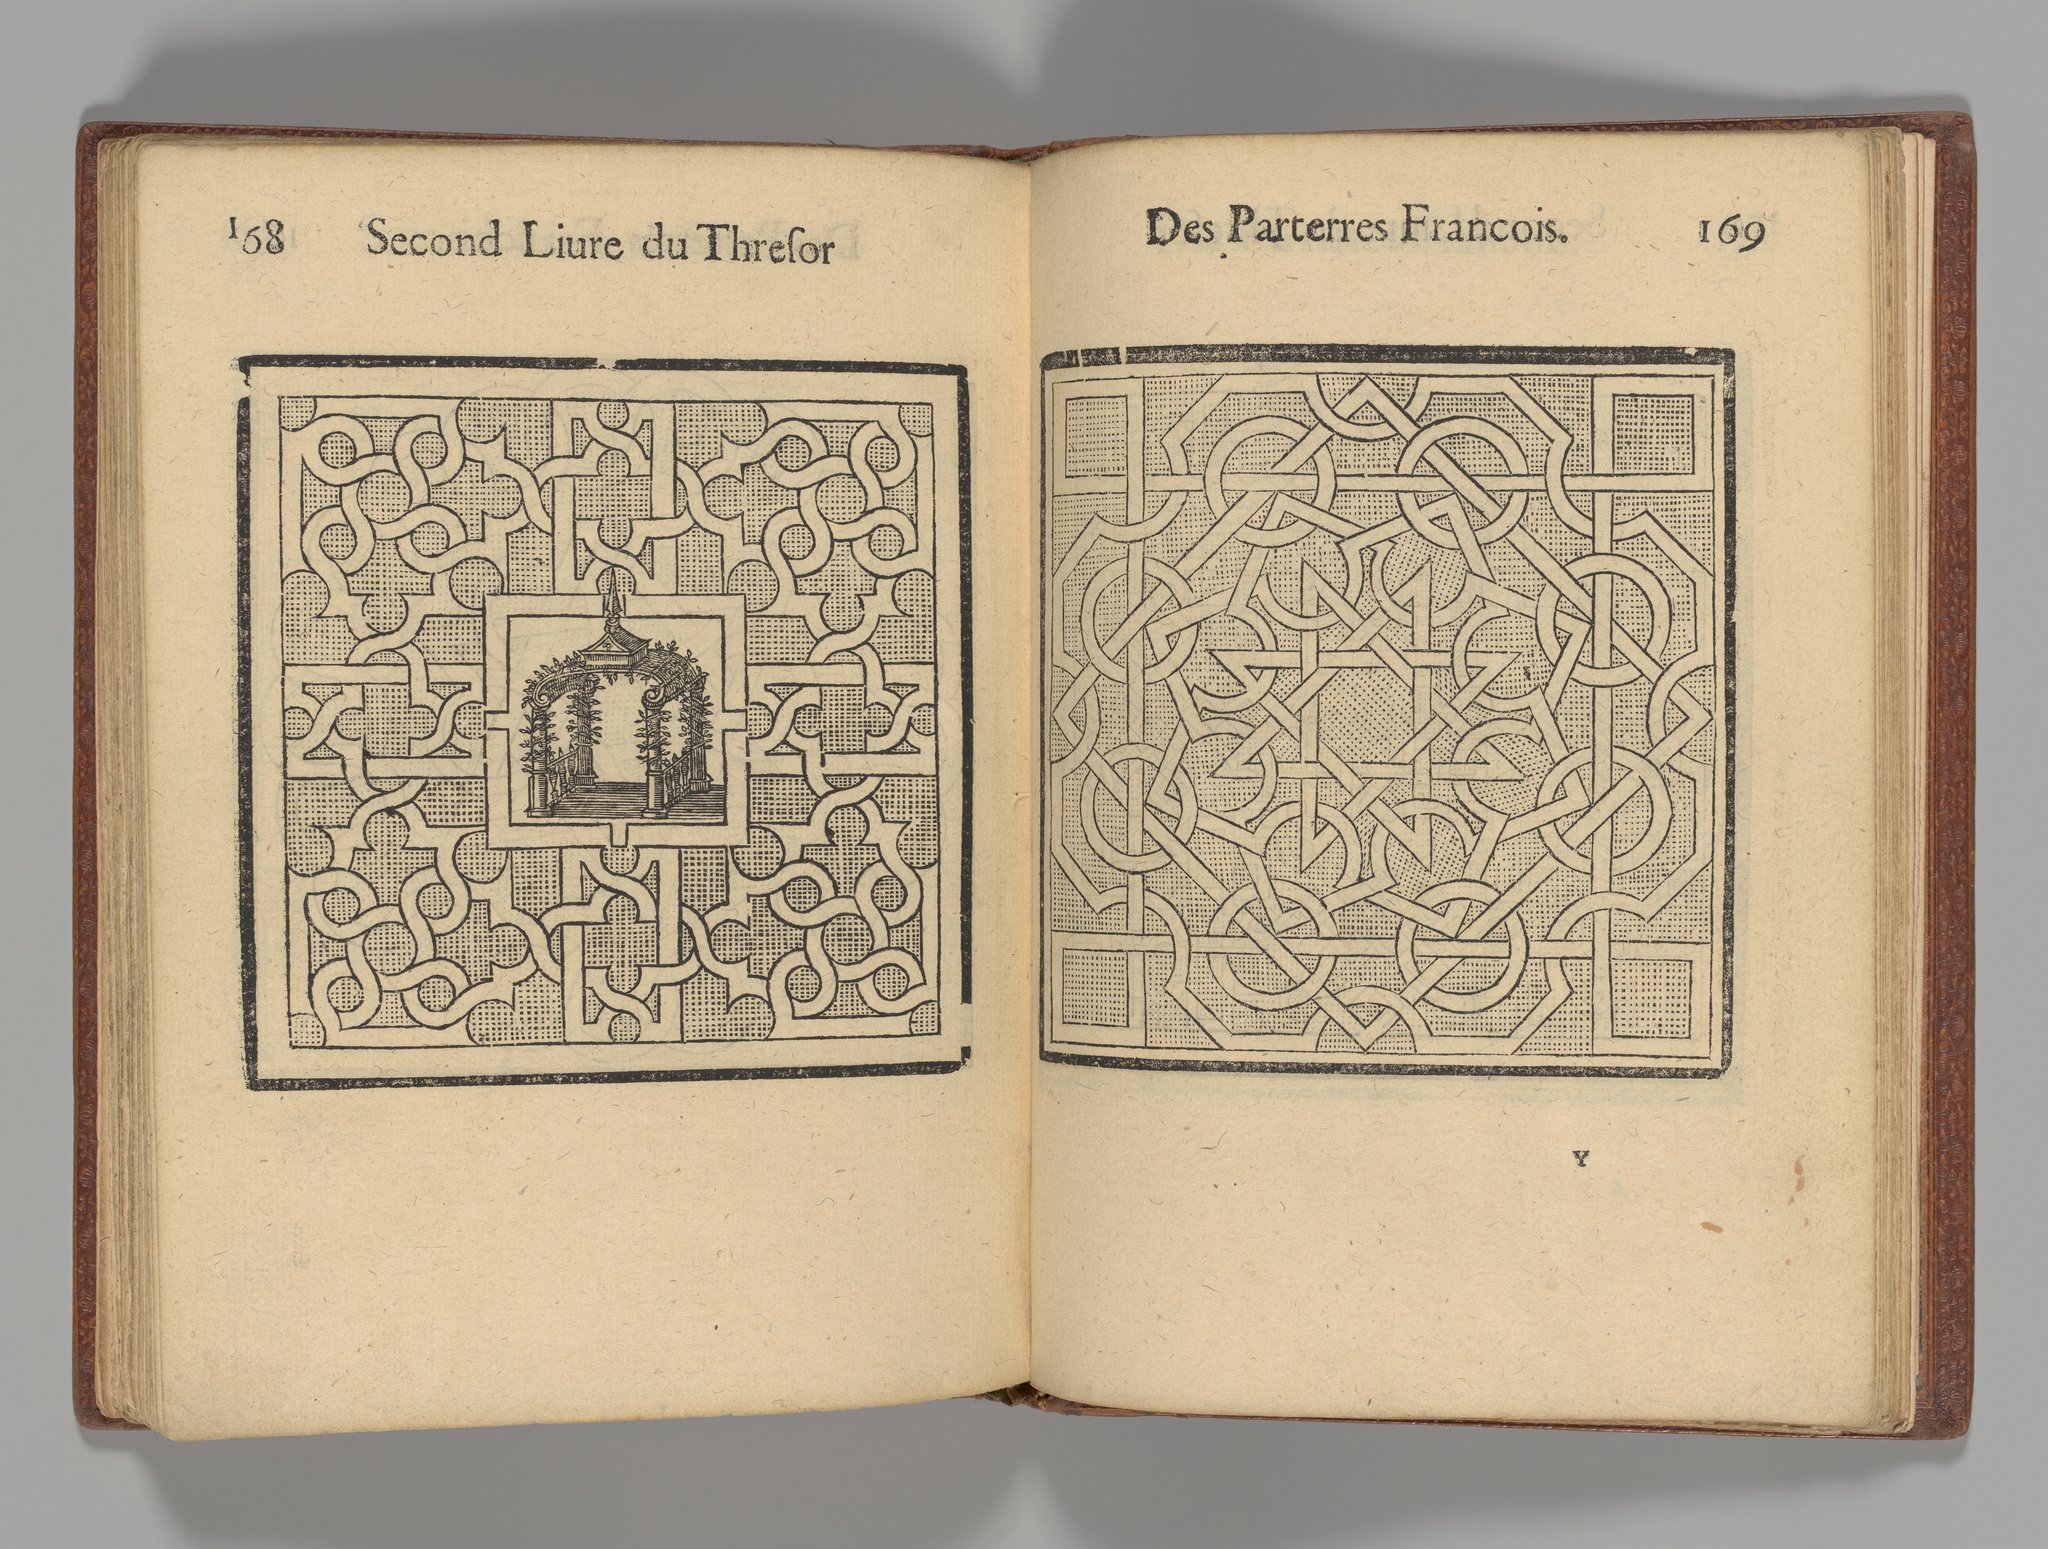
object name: book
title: Le Thresor des Parterres de l'Univers, Contenant les Figures et Pourtraits des Plus Beaux Compartimens, Cabanes, & Labyrinthes des Jardinages...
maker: daniel loris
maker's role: author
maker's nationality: german or swiss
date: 1629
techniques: woodcut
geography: geneva